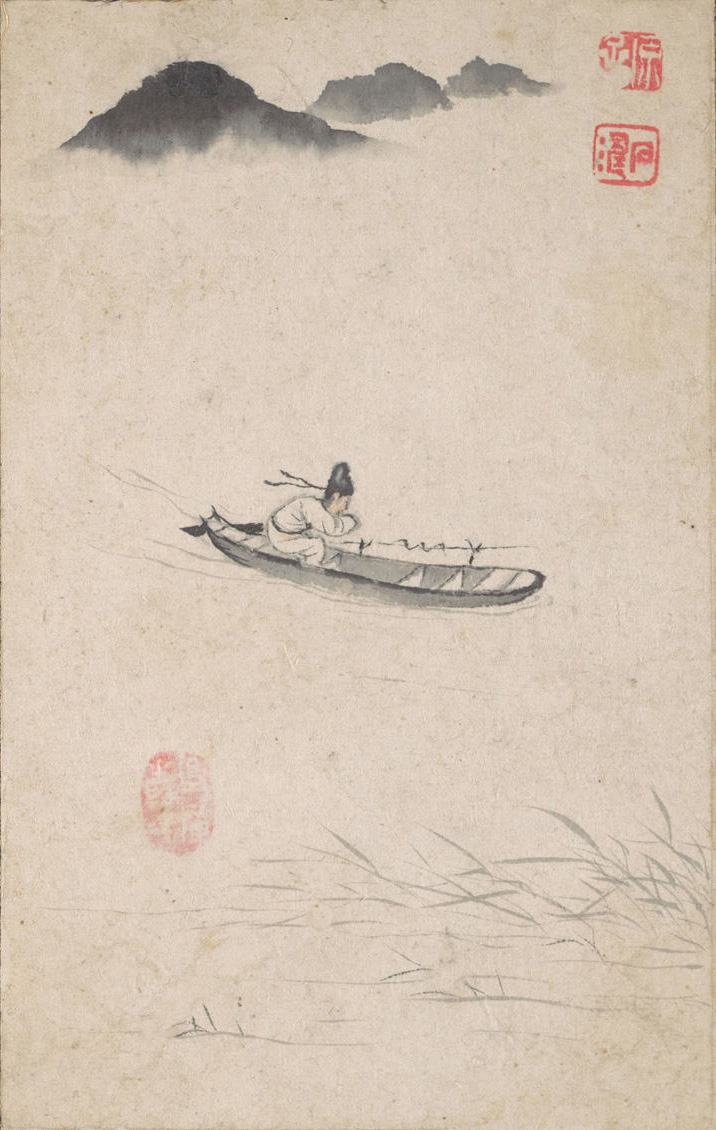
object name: album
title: Returning Home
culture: chinese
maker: shitao (zhu ruoji)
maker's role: artist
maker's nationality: chinese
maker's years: 1642-1707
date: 1695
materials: ink, paper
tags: landscapes,boats